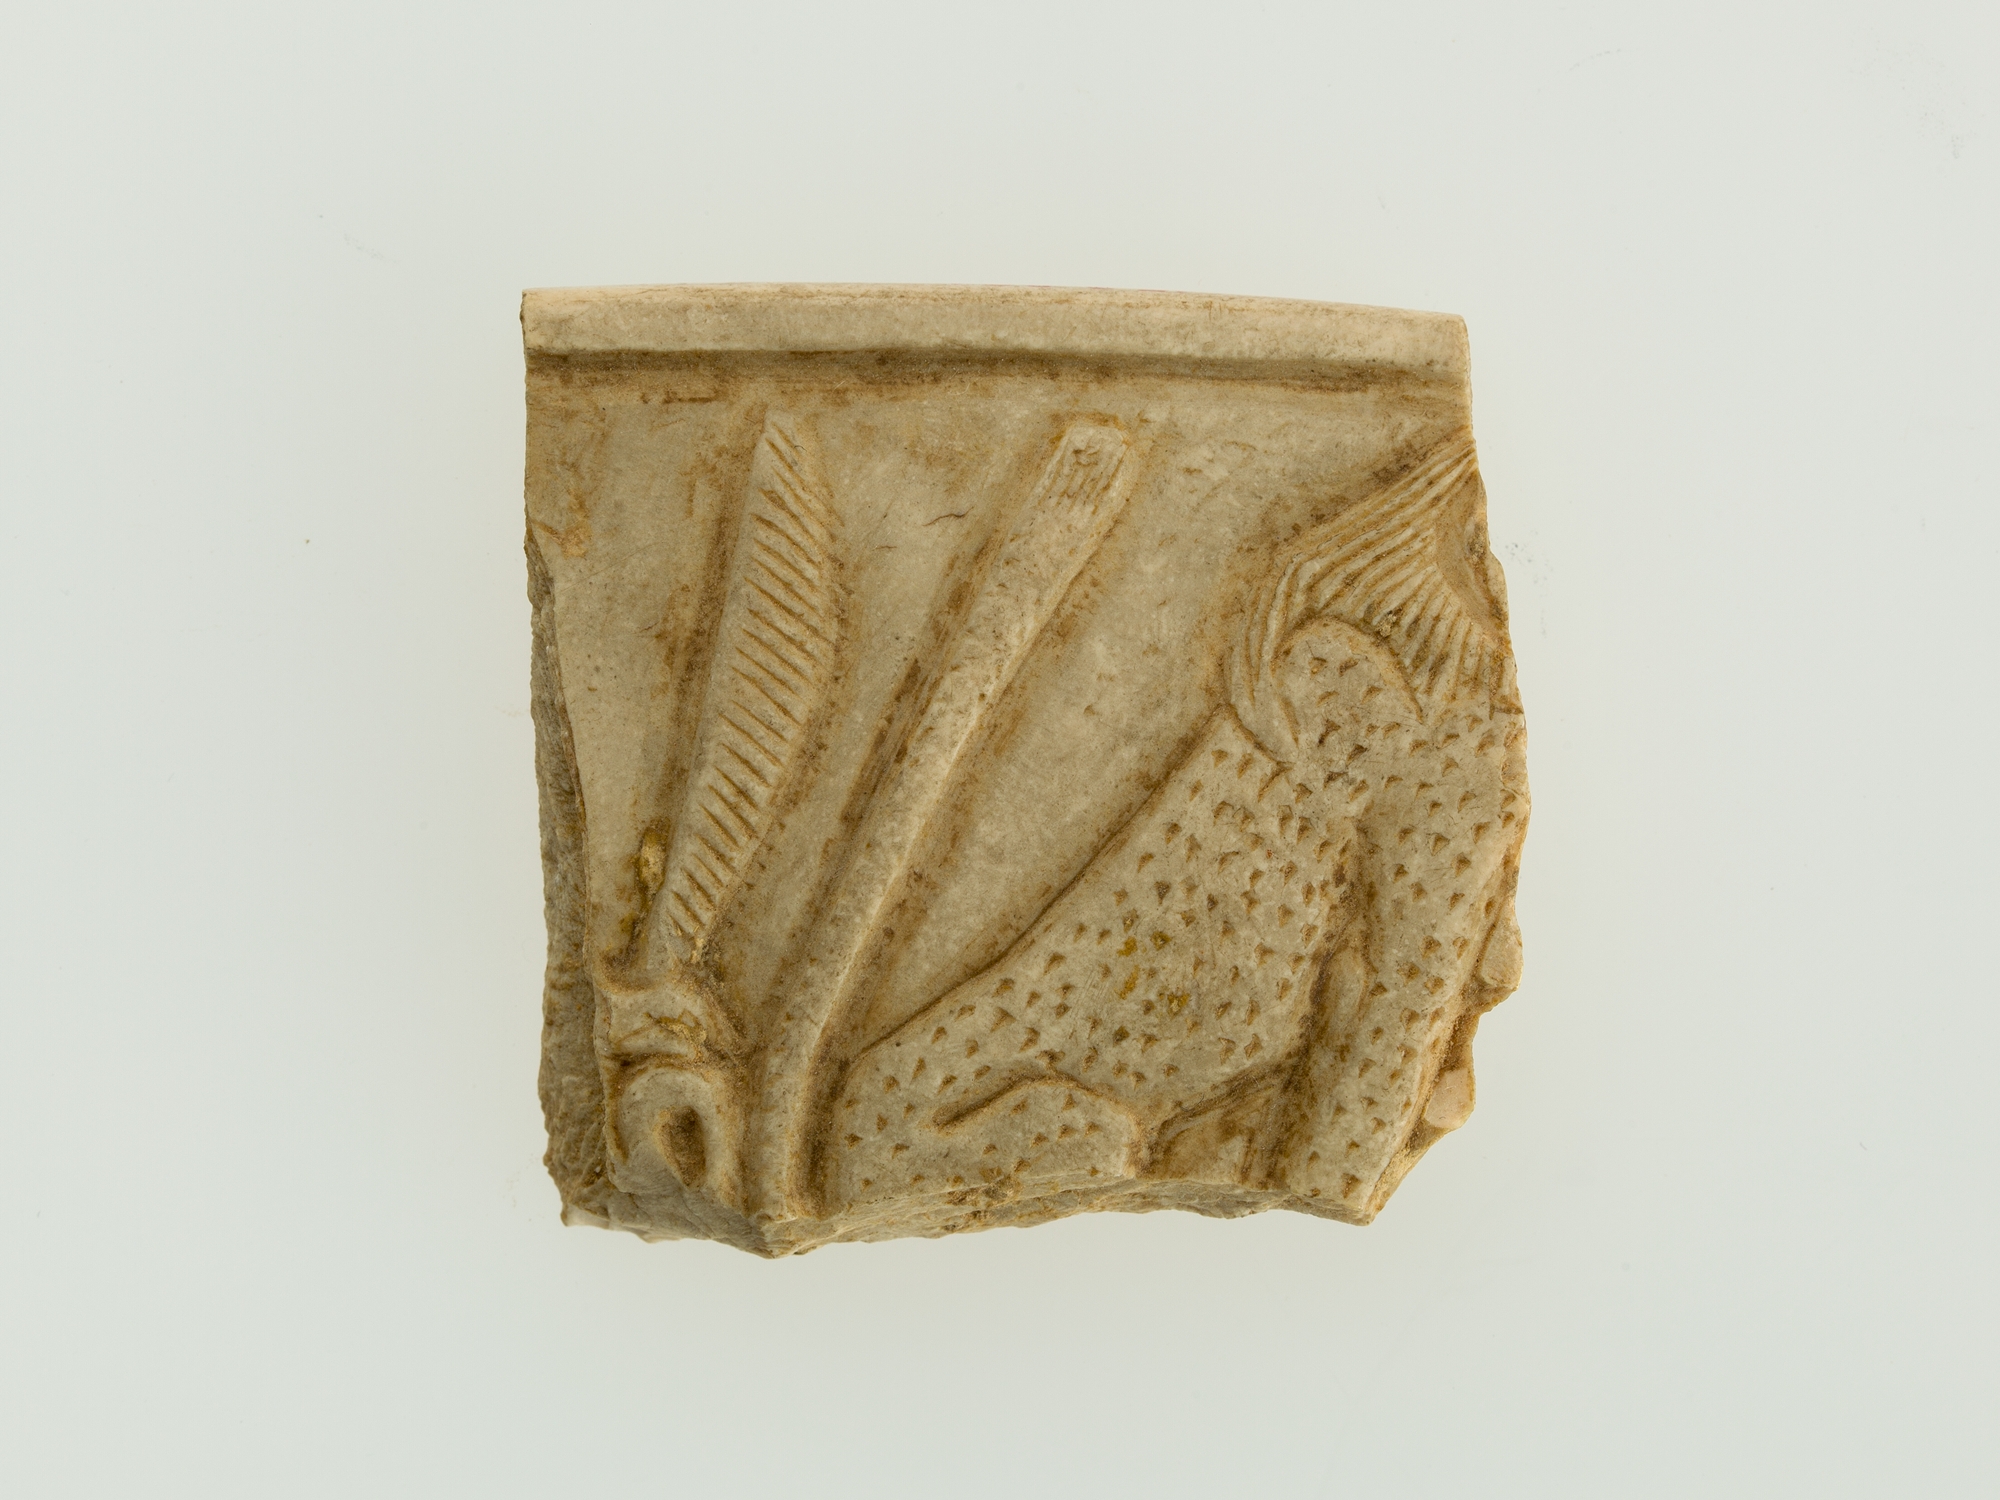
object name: magic wand fragment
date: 1802-1640 BCE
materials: ivory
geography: egypt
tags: lions